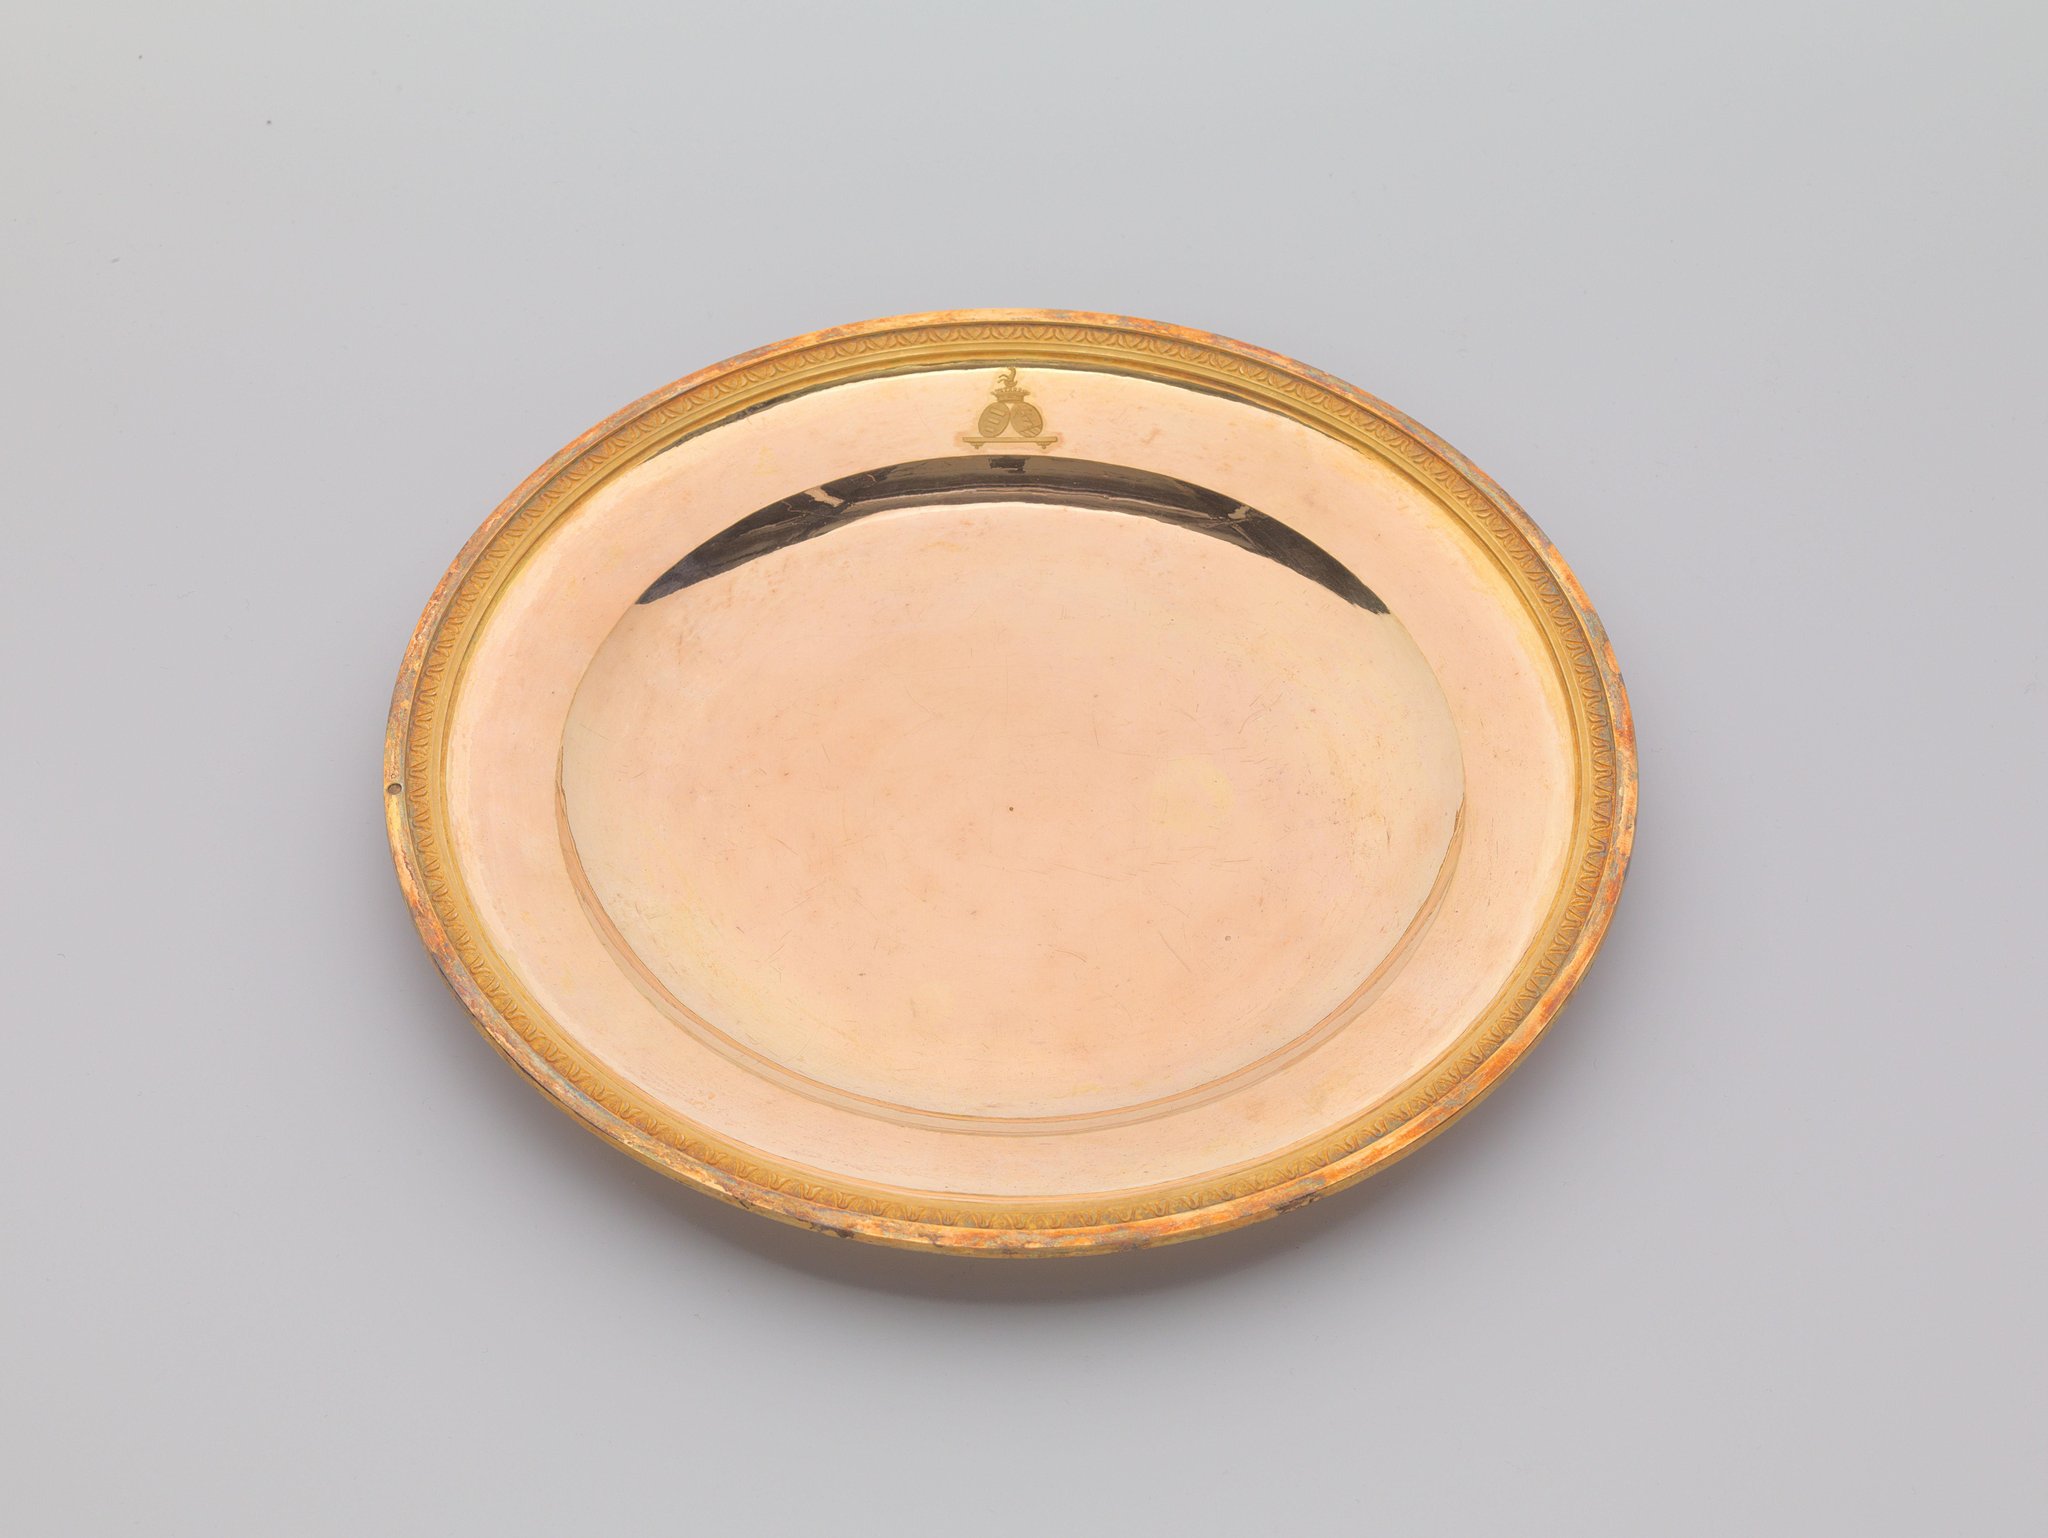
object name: plate dish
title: Bord van verguld zilver, met palmetrand. Op het plat het gegraveerde wapen Potemkin.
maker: Anonymous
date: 1809-1819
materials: silver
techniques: gilding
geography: paris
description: Empire bord van verguld zilver. Omgeven door een palmetrand. In het plat het gegraveerde wapen van Potemkin.